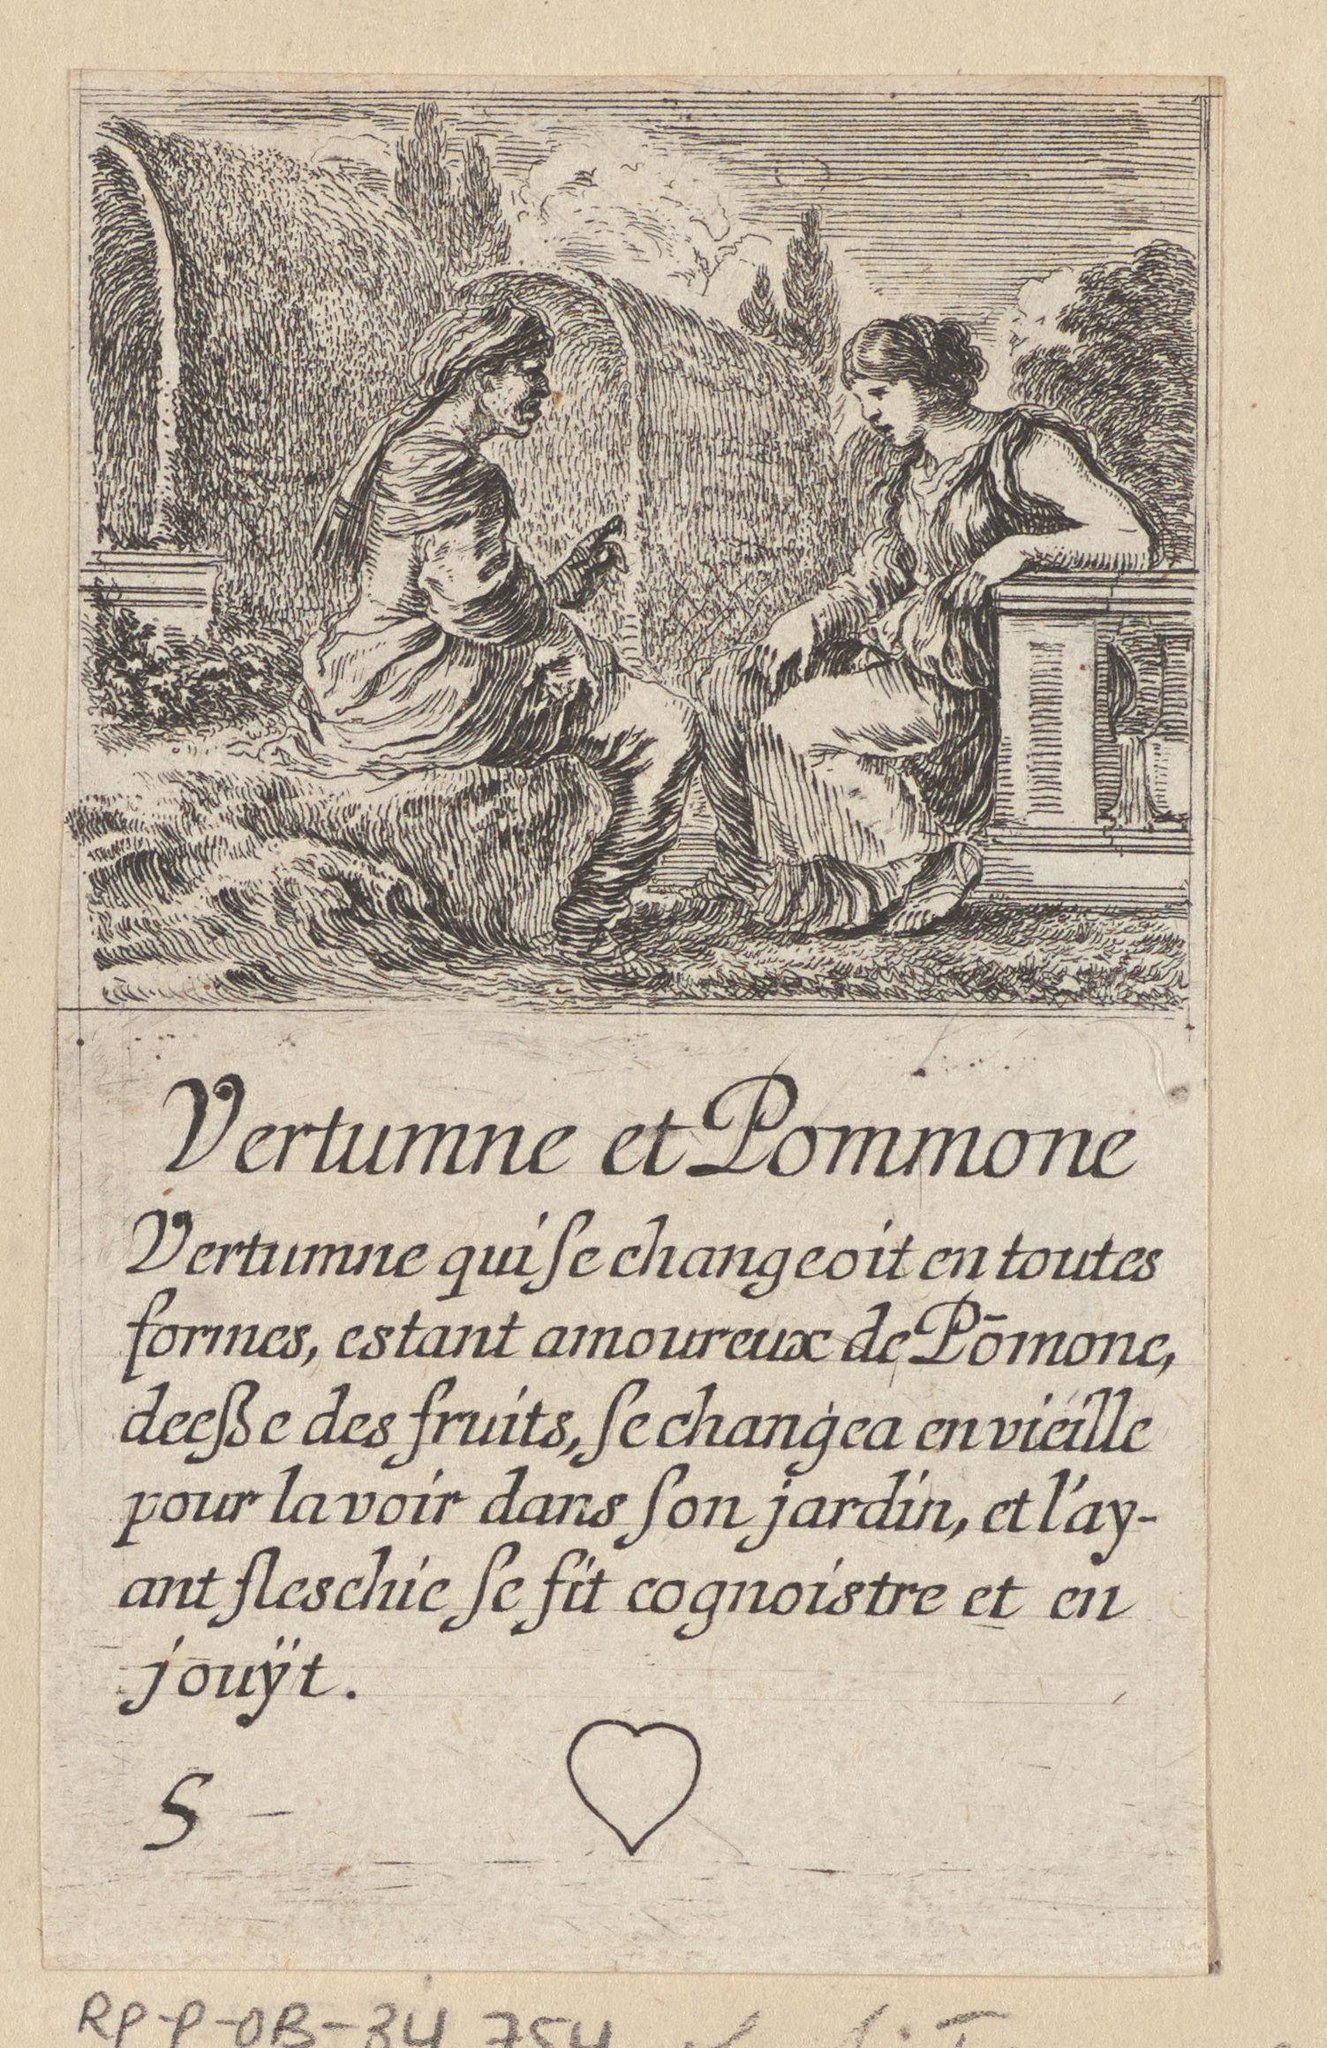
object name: print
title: Harten vijf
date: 1620-1664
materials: paper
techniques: etching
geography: paris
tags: vertumnus and pomona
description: Deze prent maakt deel uit van een kaartspel met 52 kaarten met voorstellingen uit de Metamorfosen van Ovidius. De serie is uitgedacht door Jean Desmarests de Saint-Sorlin in opdracht van Kardinaal Mazarin. Het kaartspel werd gemaakt voor de jonge Lodewijk XIV, samen met het Jeu des Reynes Renommées, Jeu de la Géographie en Jeu des Rois de France.